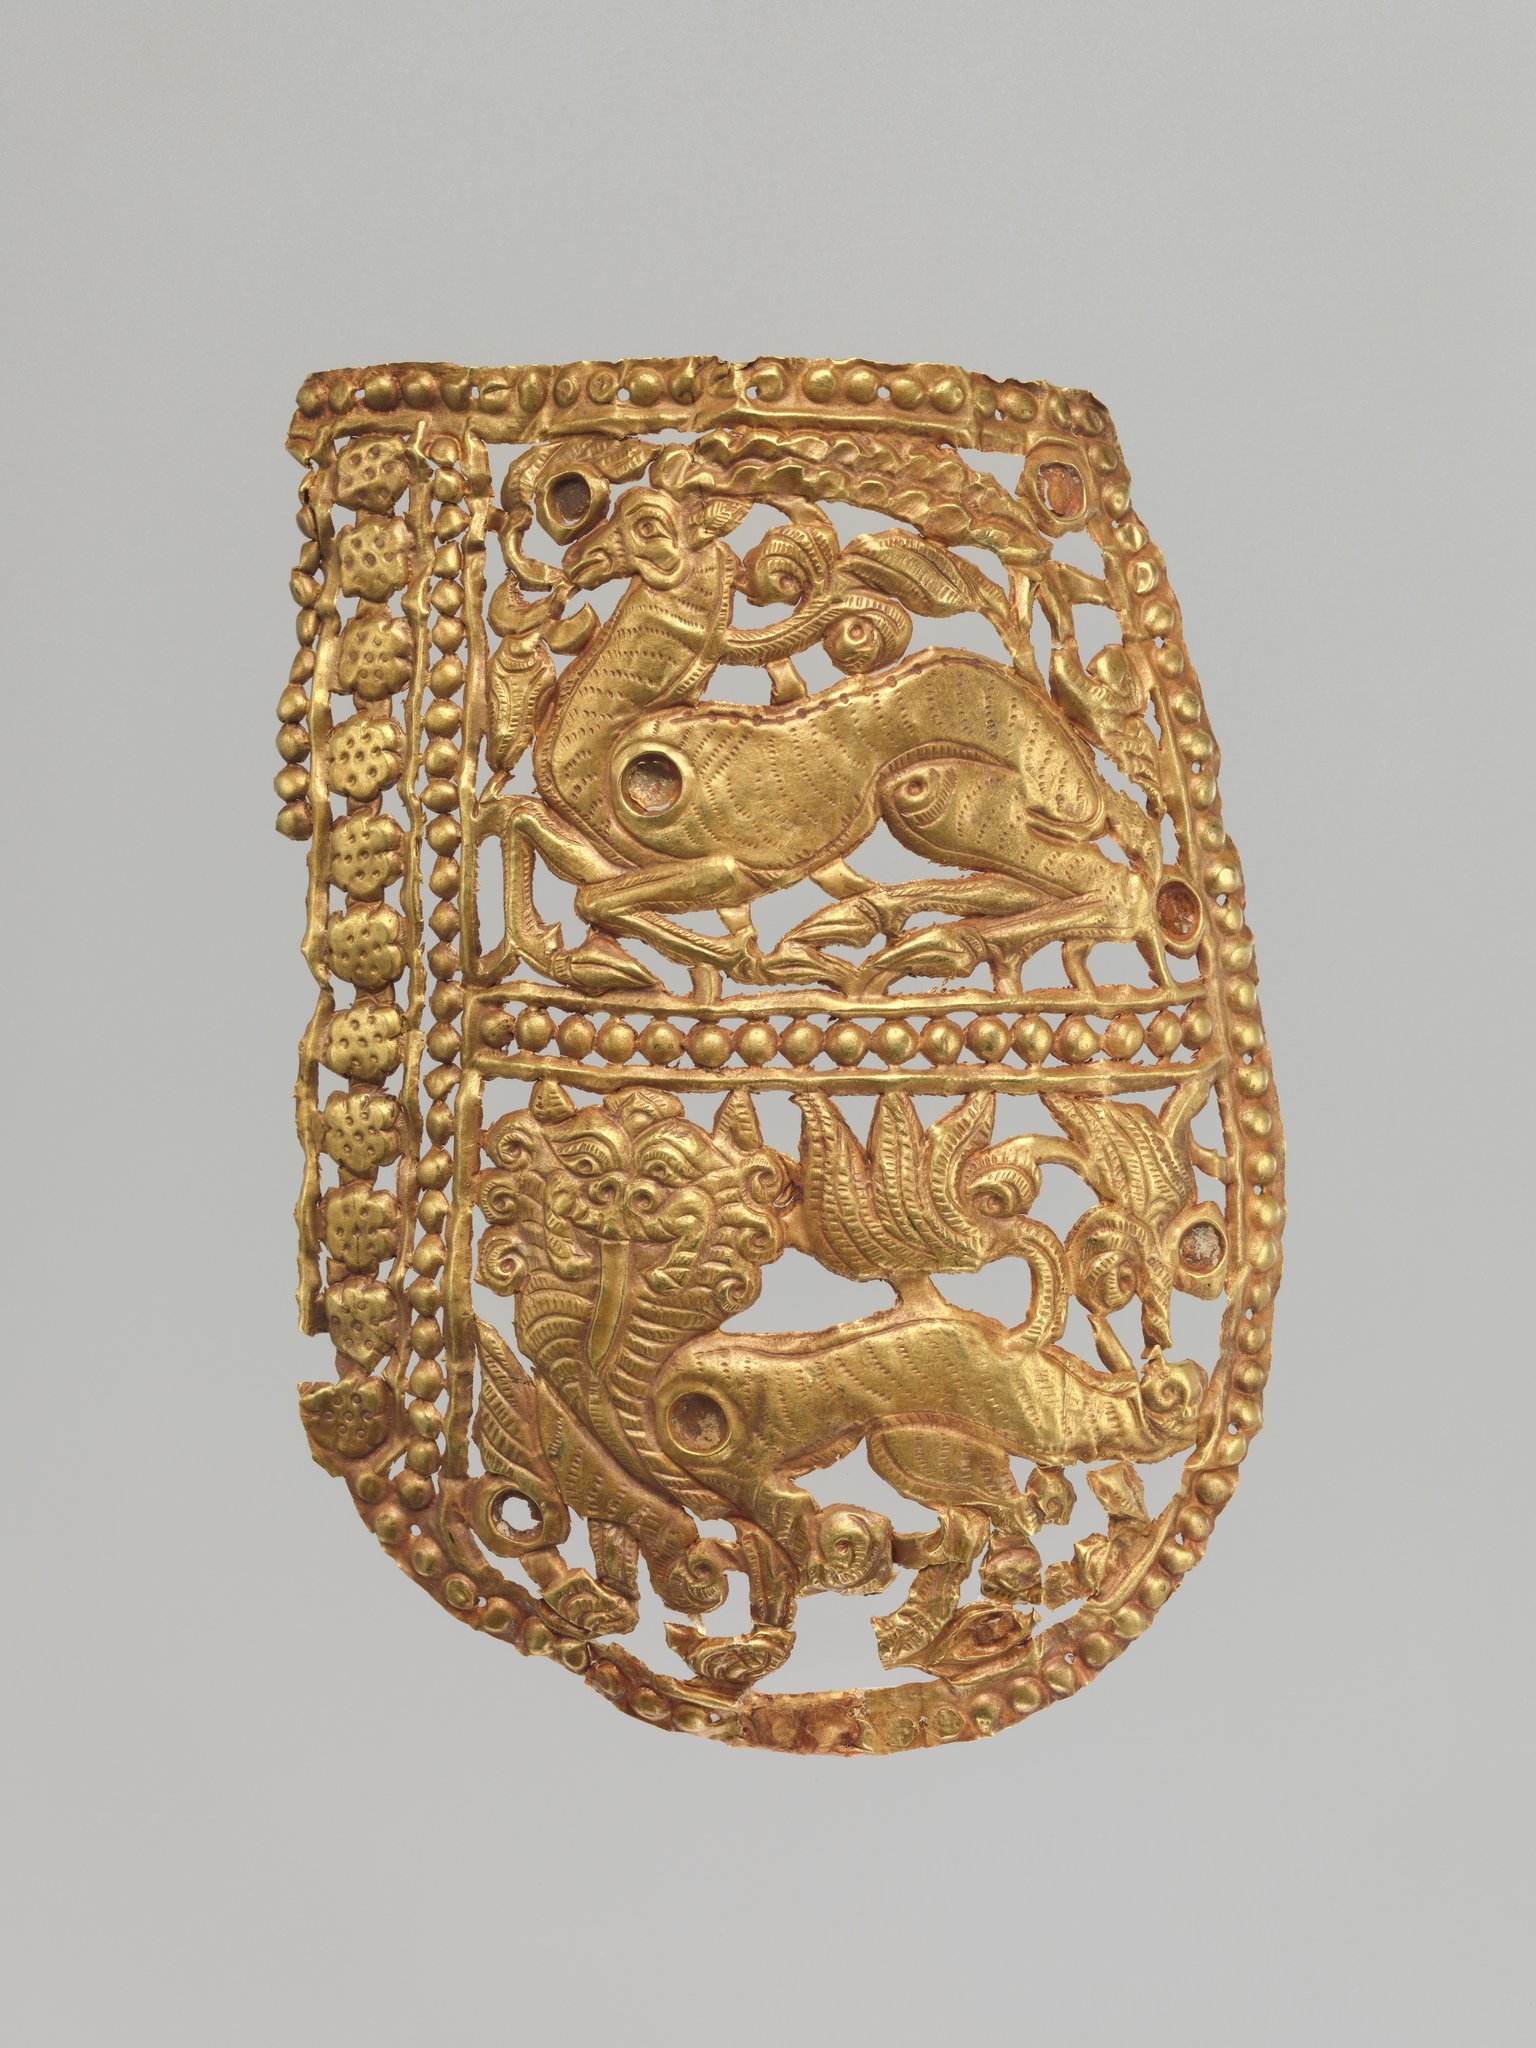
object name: garment plaque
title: Clothing Plaque with Antelope and Tiger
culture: chinese or central asian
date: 601-900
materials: gold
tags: tigers